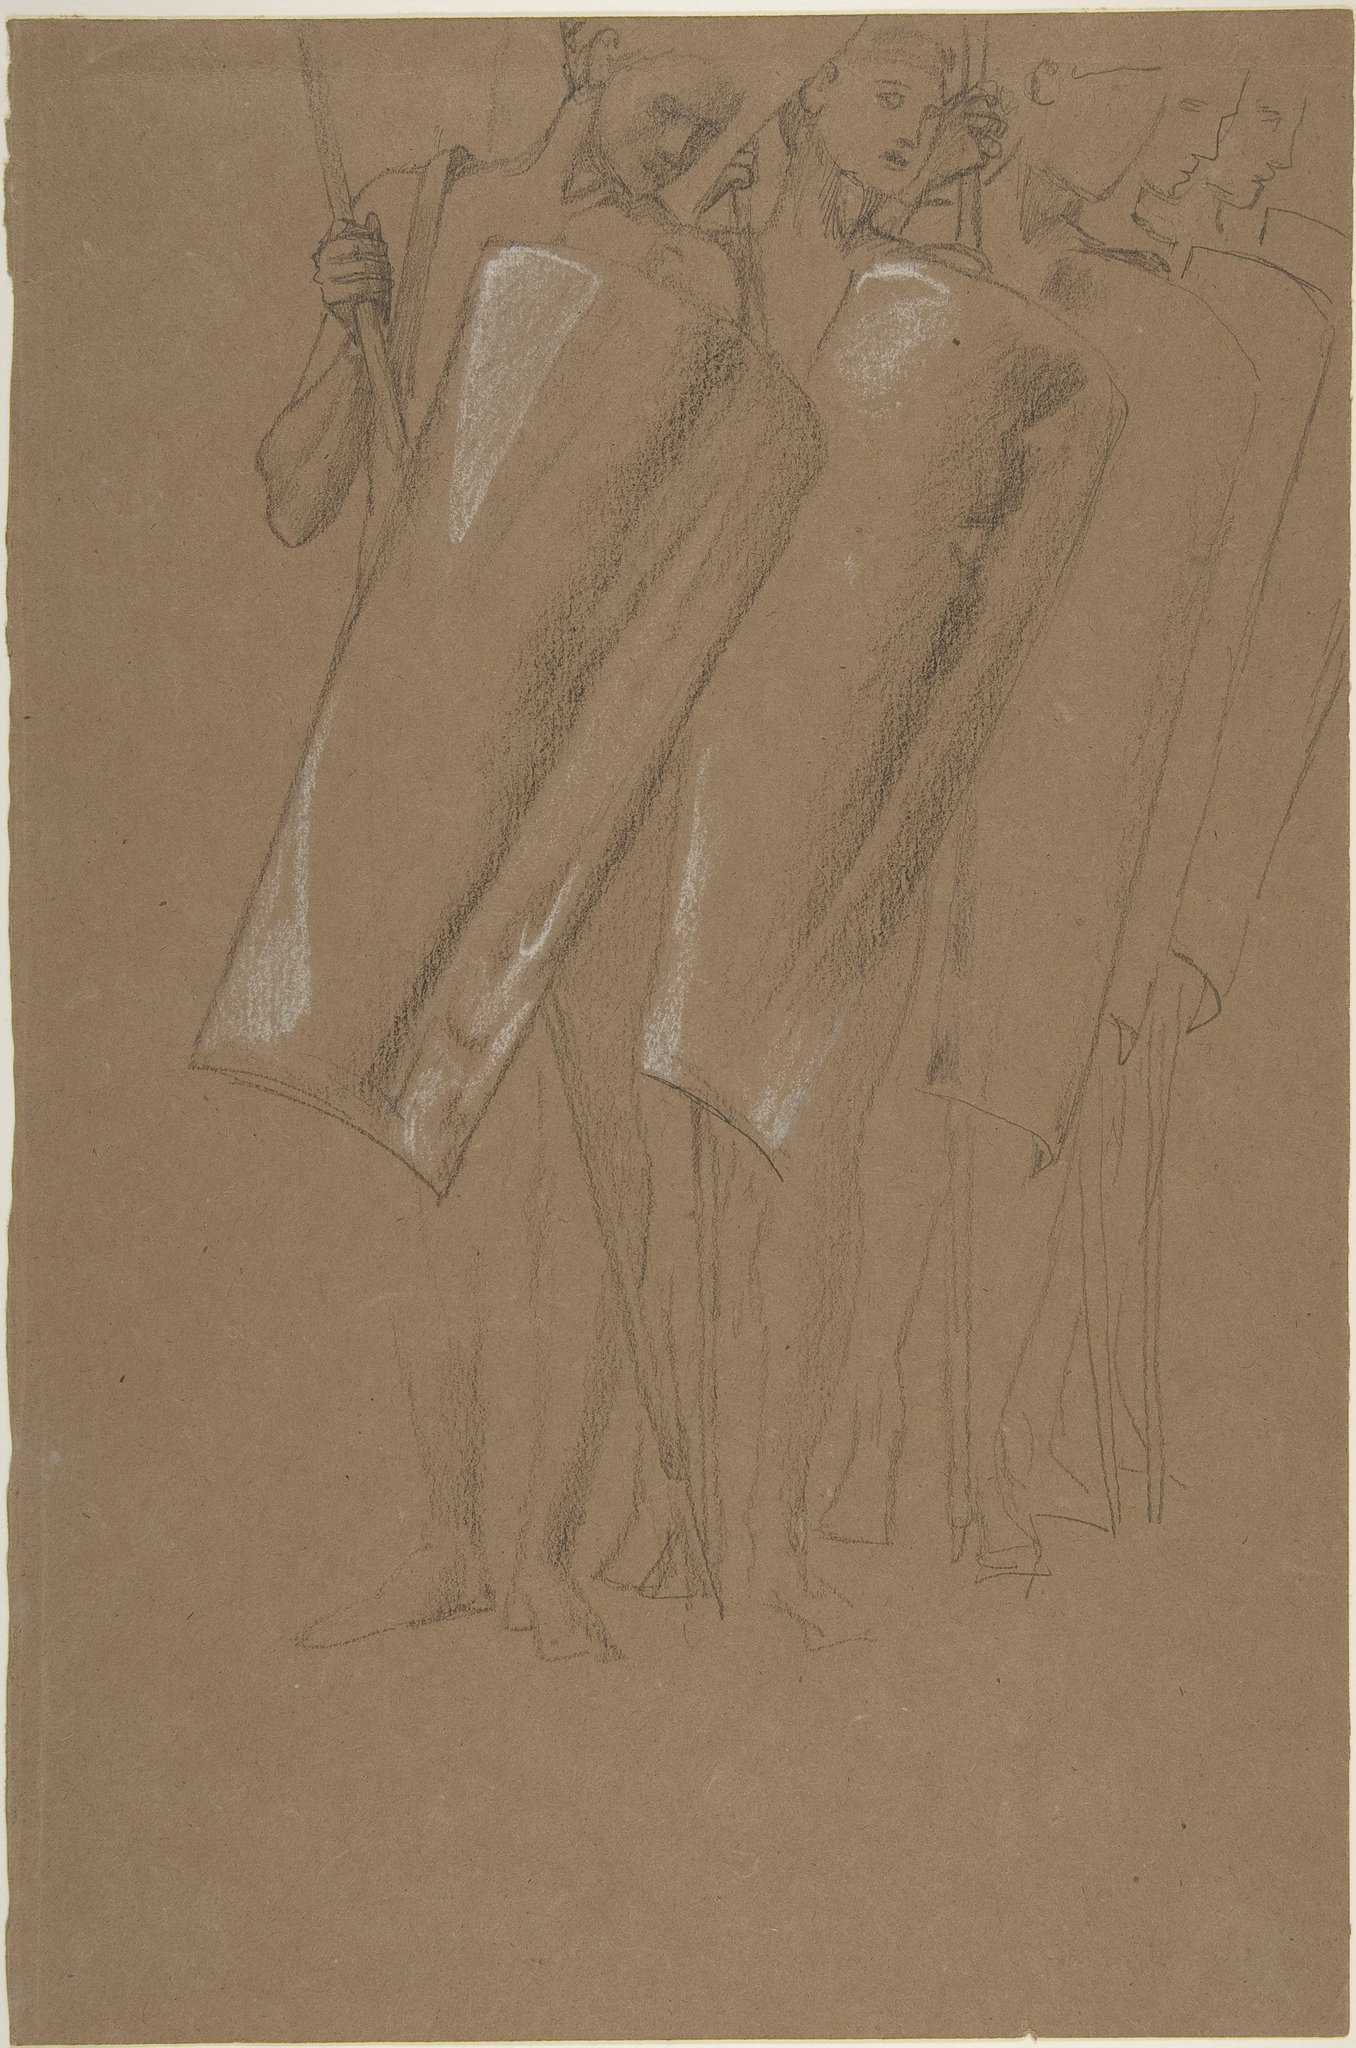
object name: drawing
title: Armed Men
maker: sir edward burne-jones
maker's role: artist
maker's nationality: british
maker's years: 1833-1898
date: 1855-1898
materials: chalk, graphite, paper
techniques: heightening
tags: soldiers,shields,spears,men